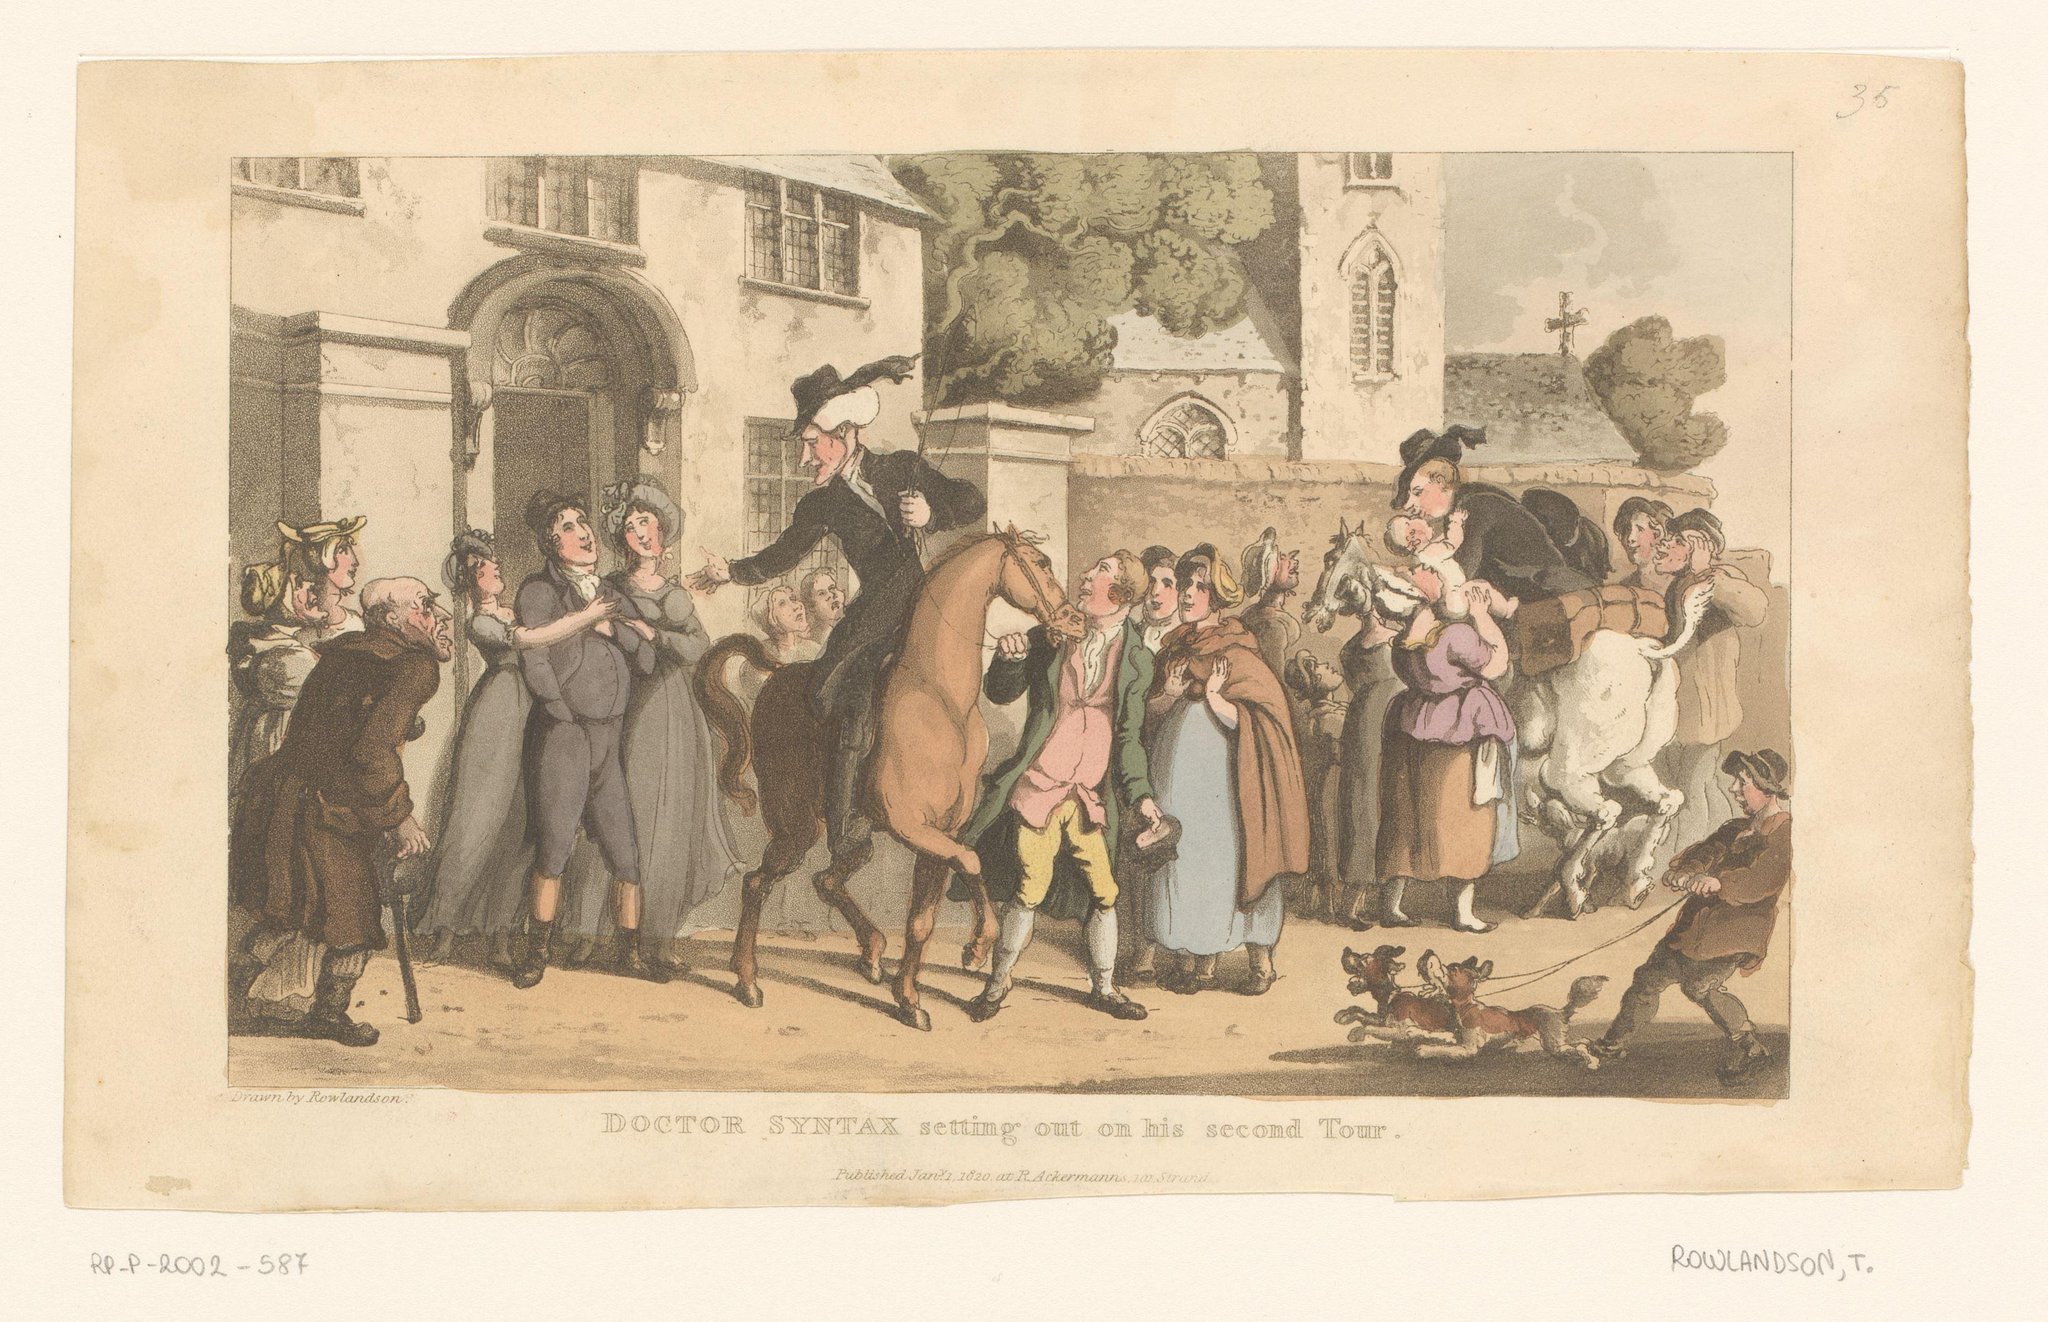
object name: book illustration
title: Doctor Syntax vertrekt op zijn paard uit het dorp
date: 1801-1820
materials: paper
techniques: aquatint, etching, hand coloring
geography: london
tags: riding a horse, ass, or mule; rider, horseman, church (exterior), waving farewell ~ departure on a journey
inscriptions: collector's mark: Lugt 2228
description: Prent ook gebruikt in: Combe, William. The second Tour of Doctor Syntax, in search of consolation; a Poem. Londen: Rudolph Ackermann, 1820.